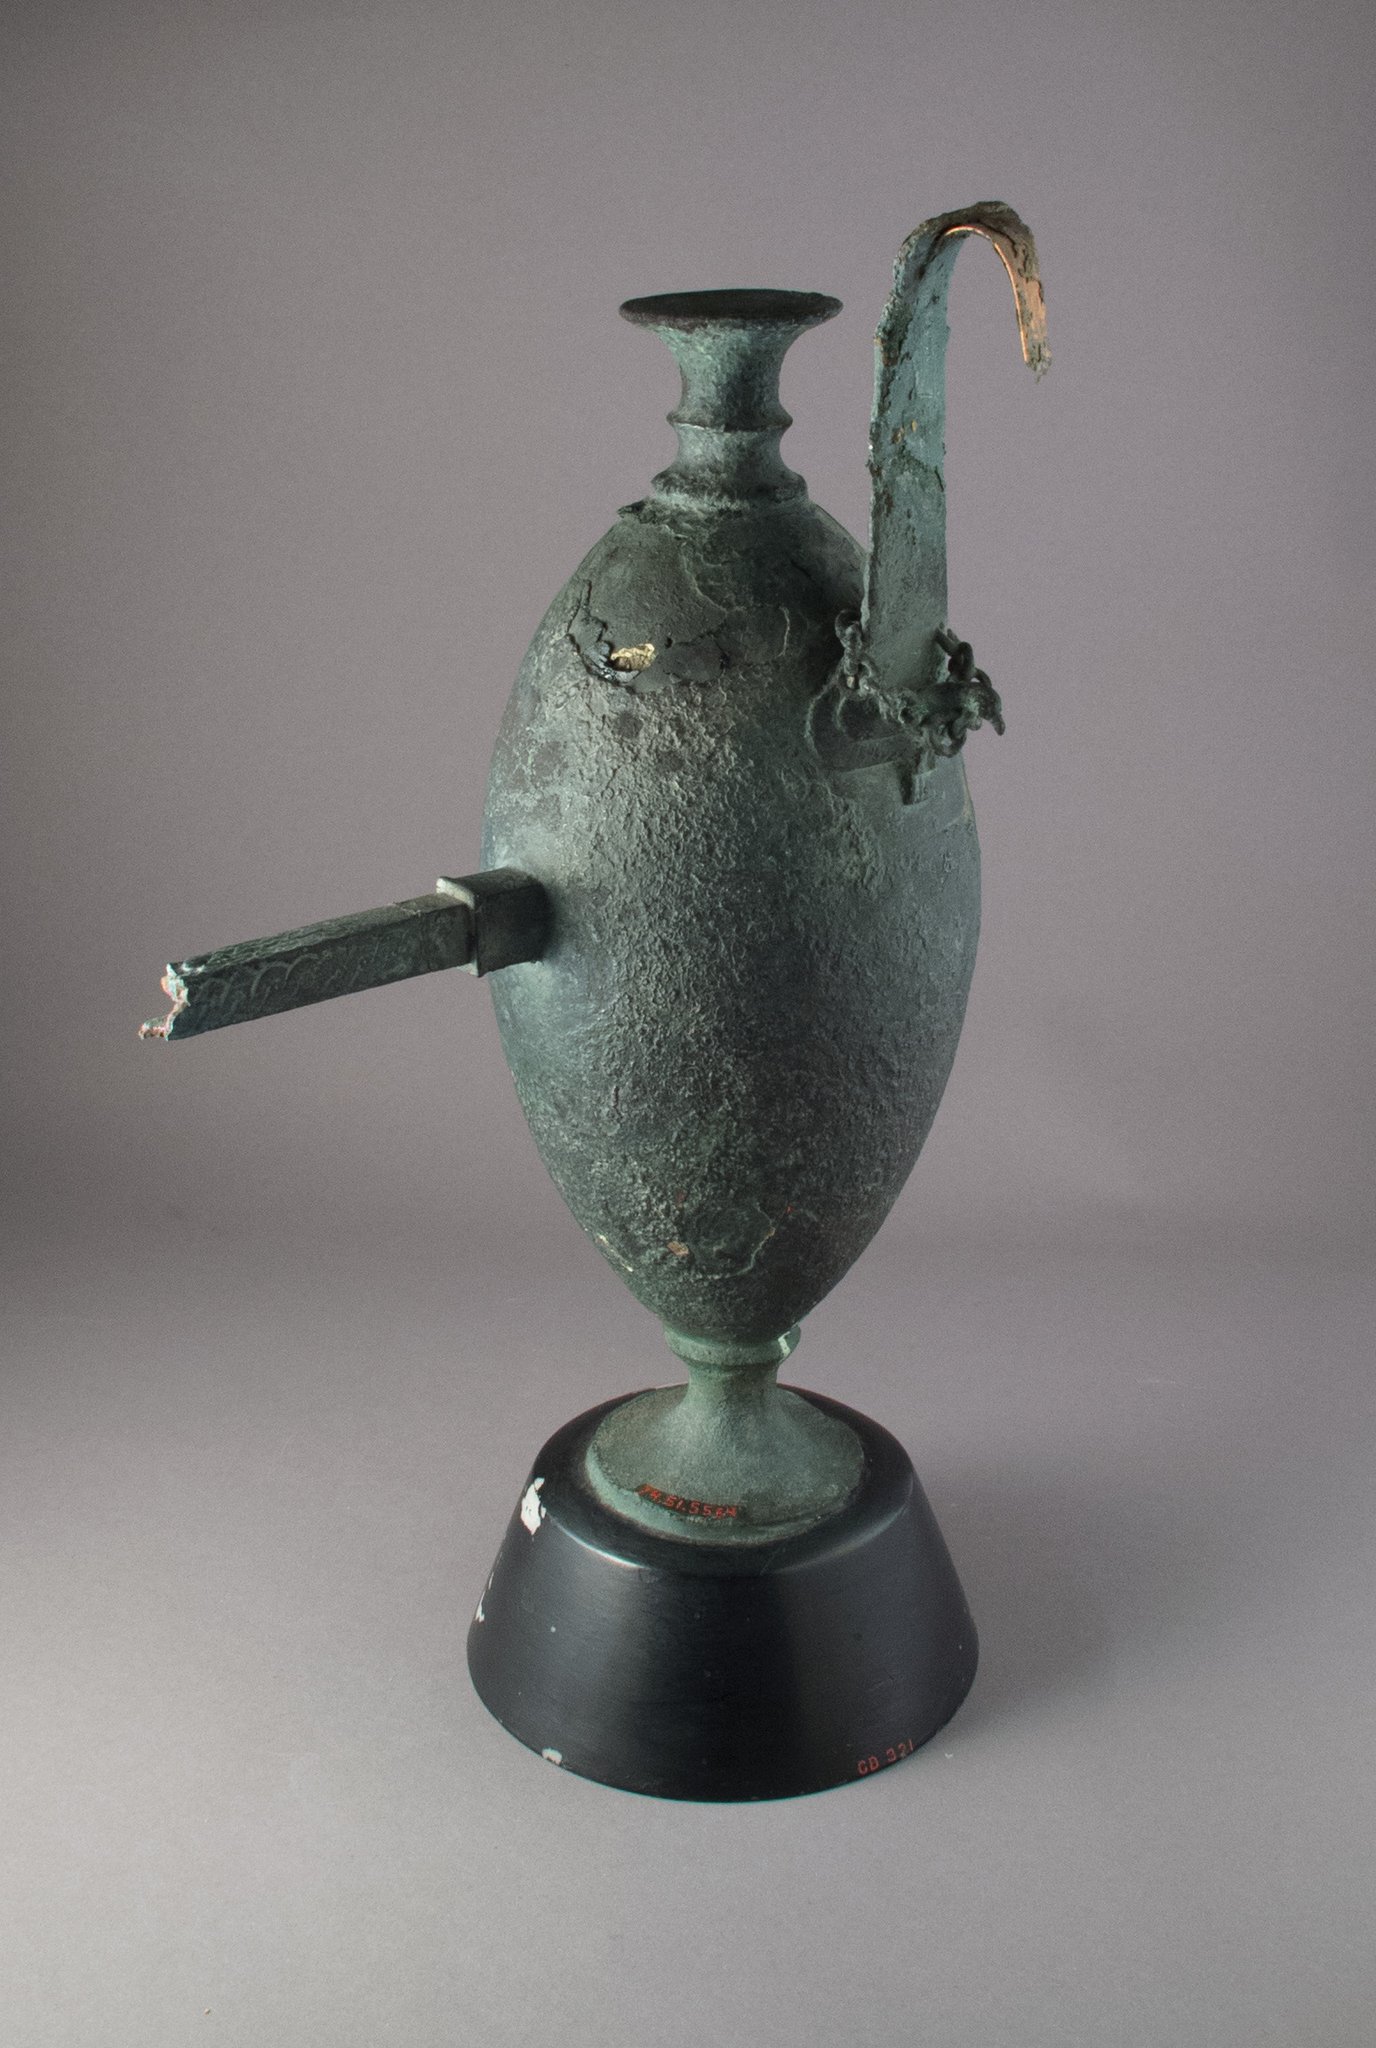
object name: vase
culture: cypriot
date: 600-501 BCE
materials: bronze